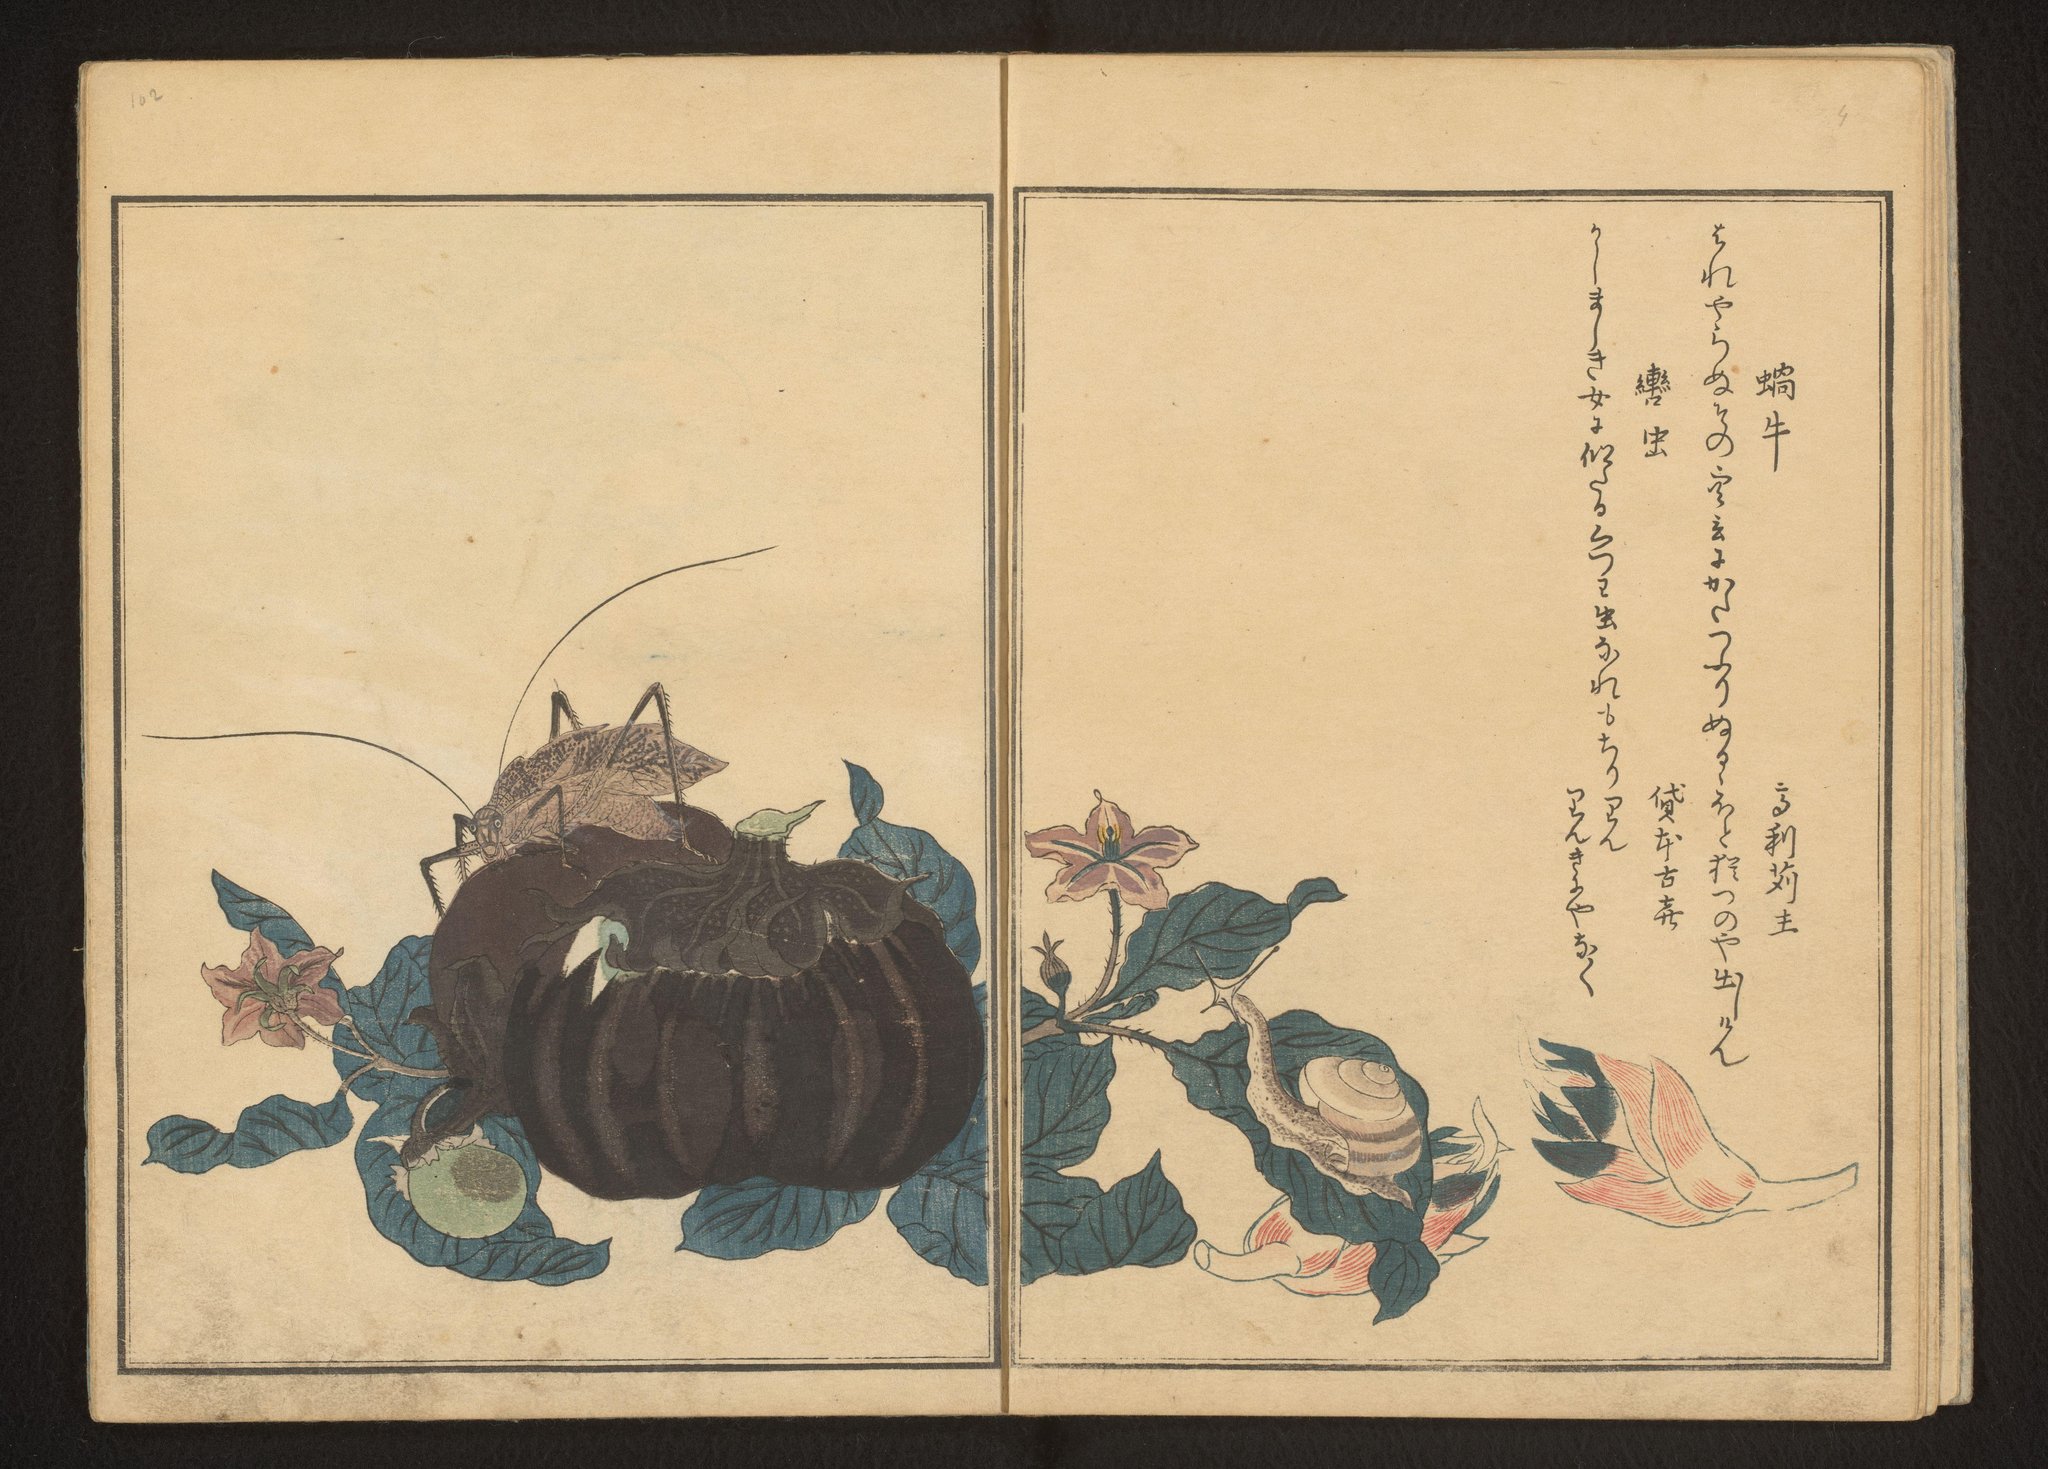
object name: page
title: Snail and noisy cricket on eggplant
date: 1788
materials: paper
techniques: woodcut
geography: edo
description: Pagina 14b en 15a van deel twee van het Insectenboek van Utamaro.